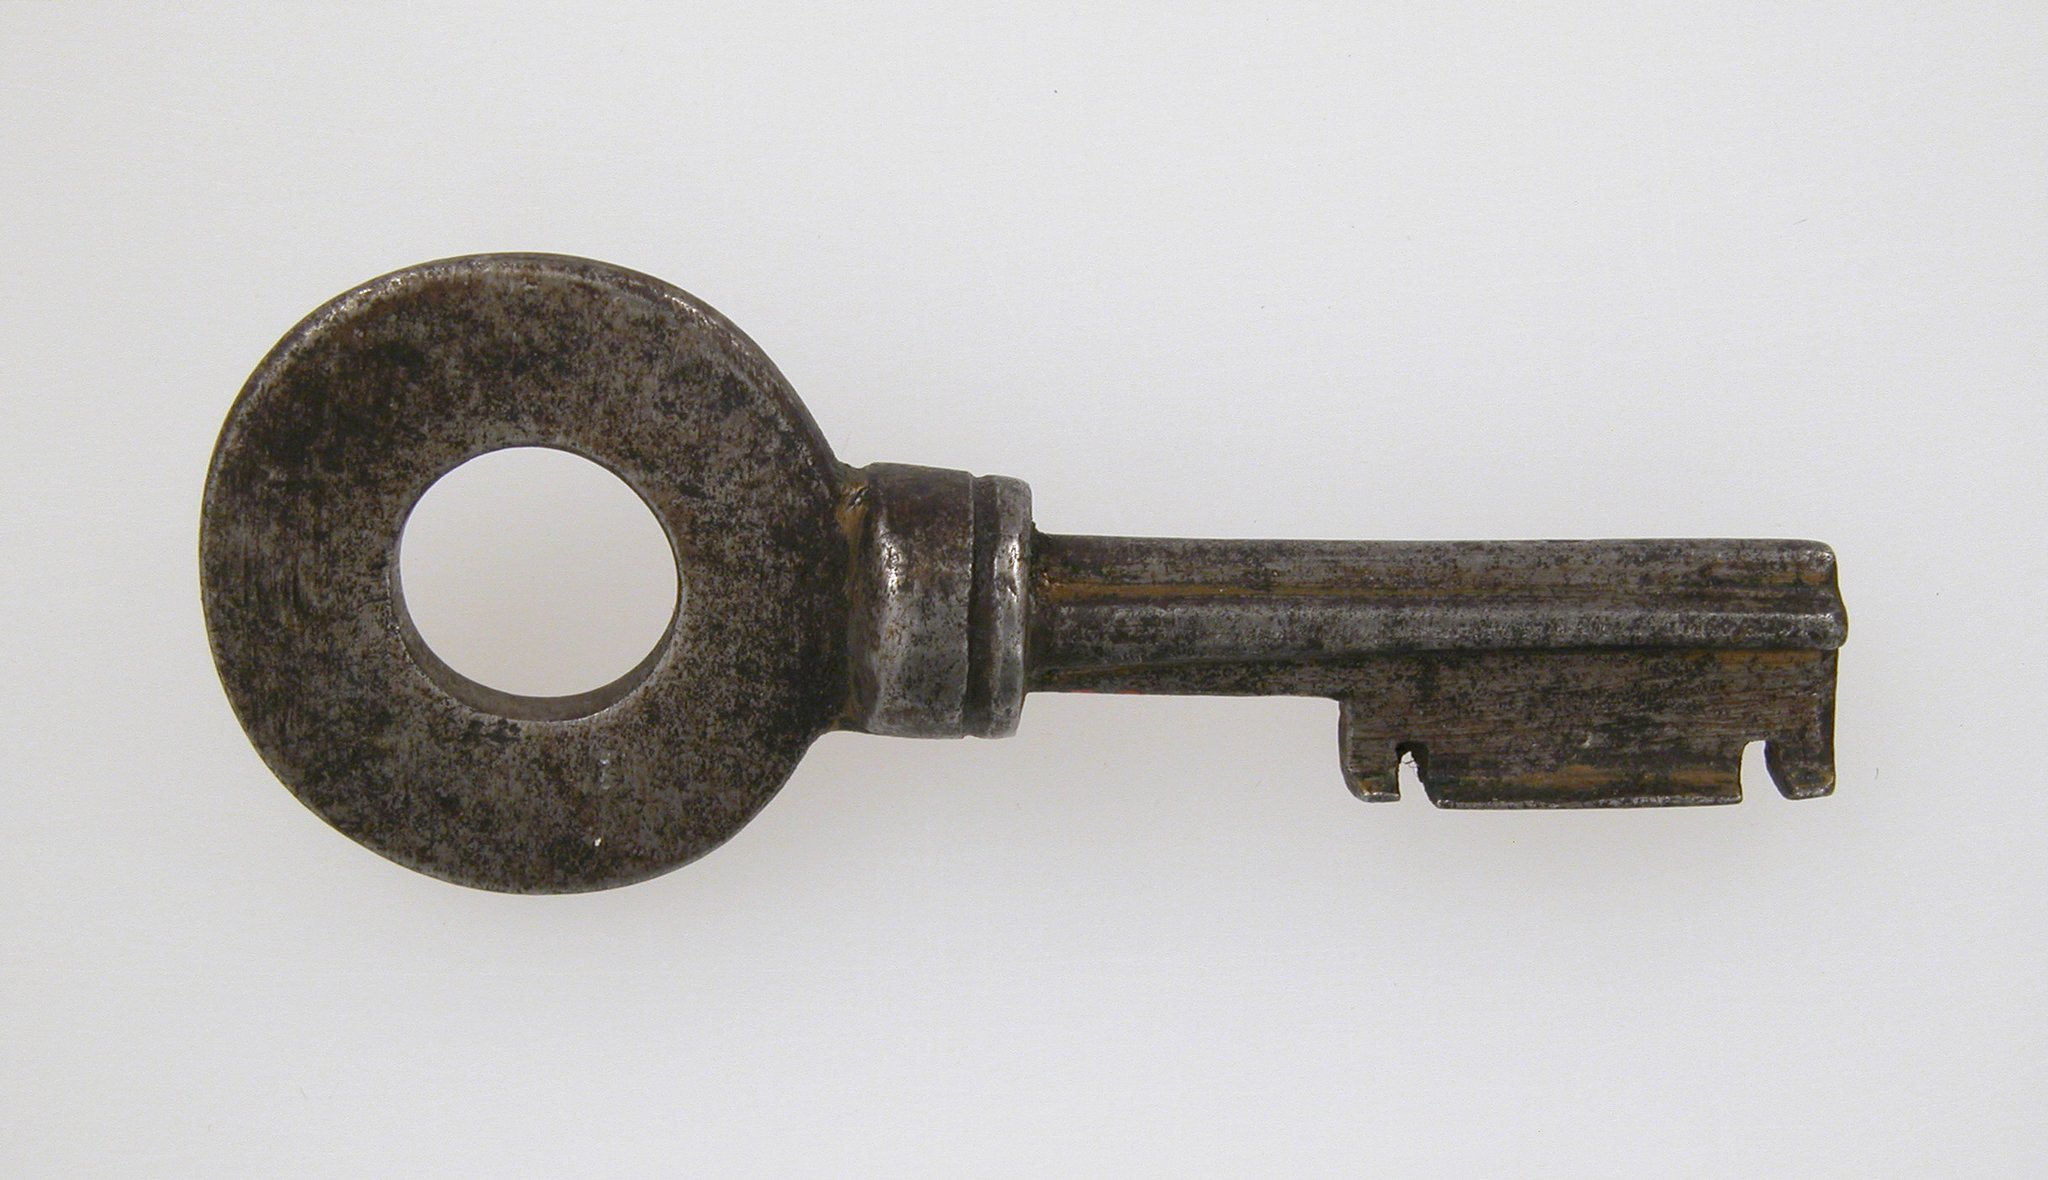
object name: key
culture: german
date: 1301-1400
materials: iron